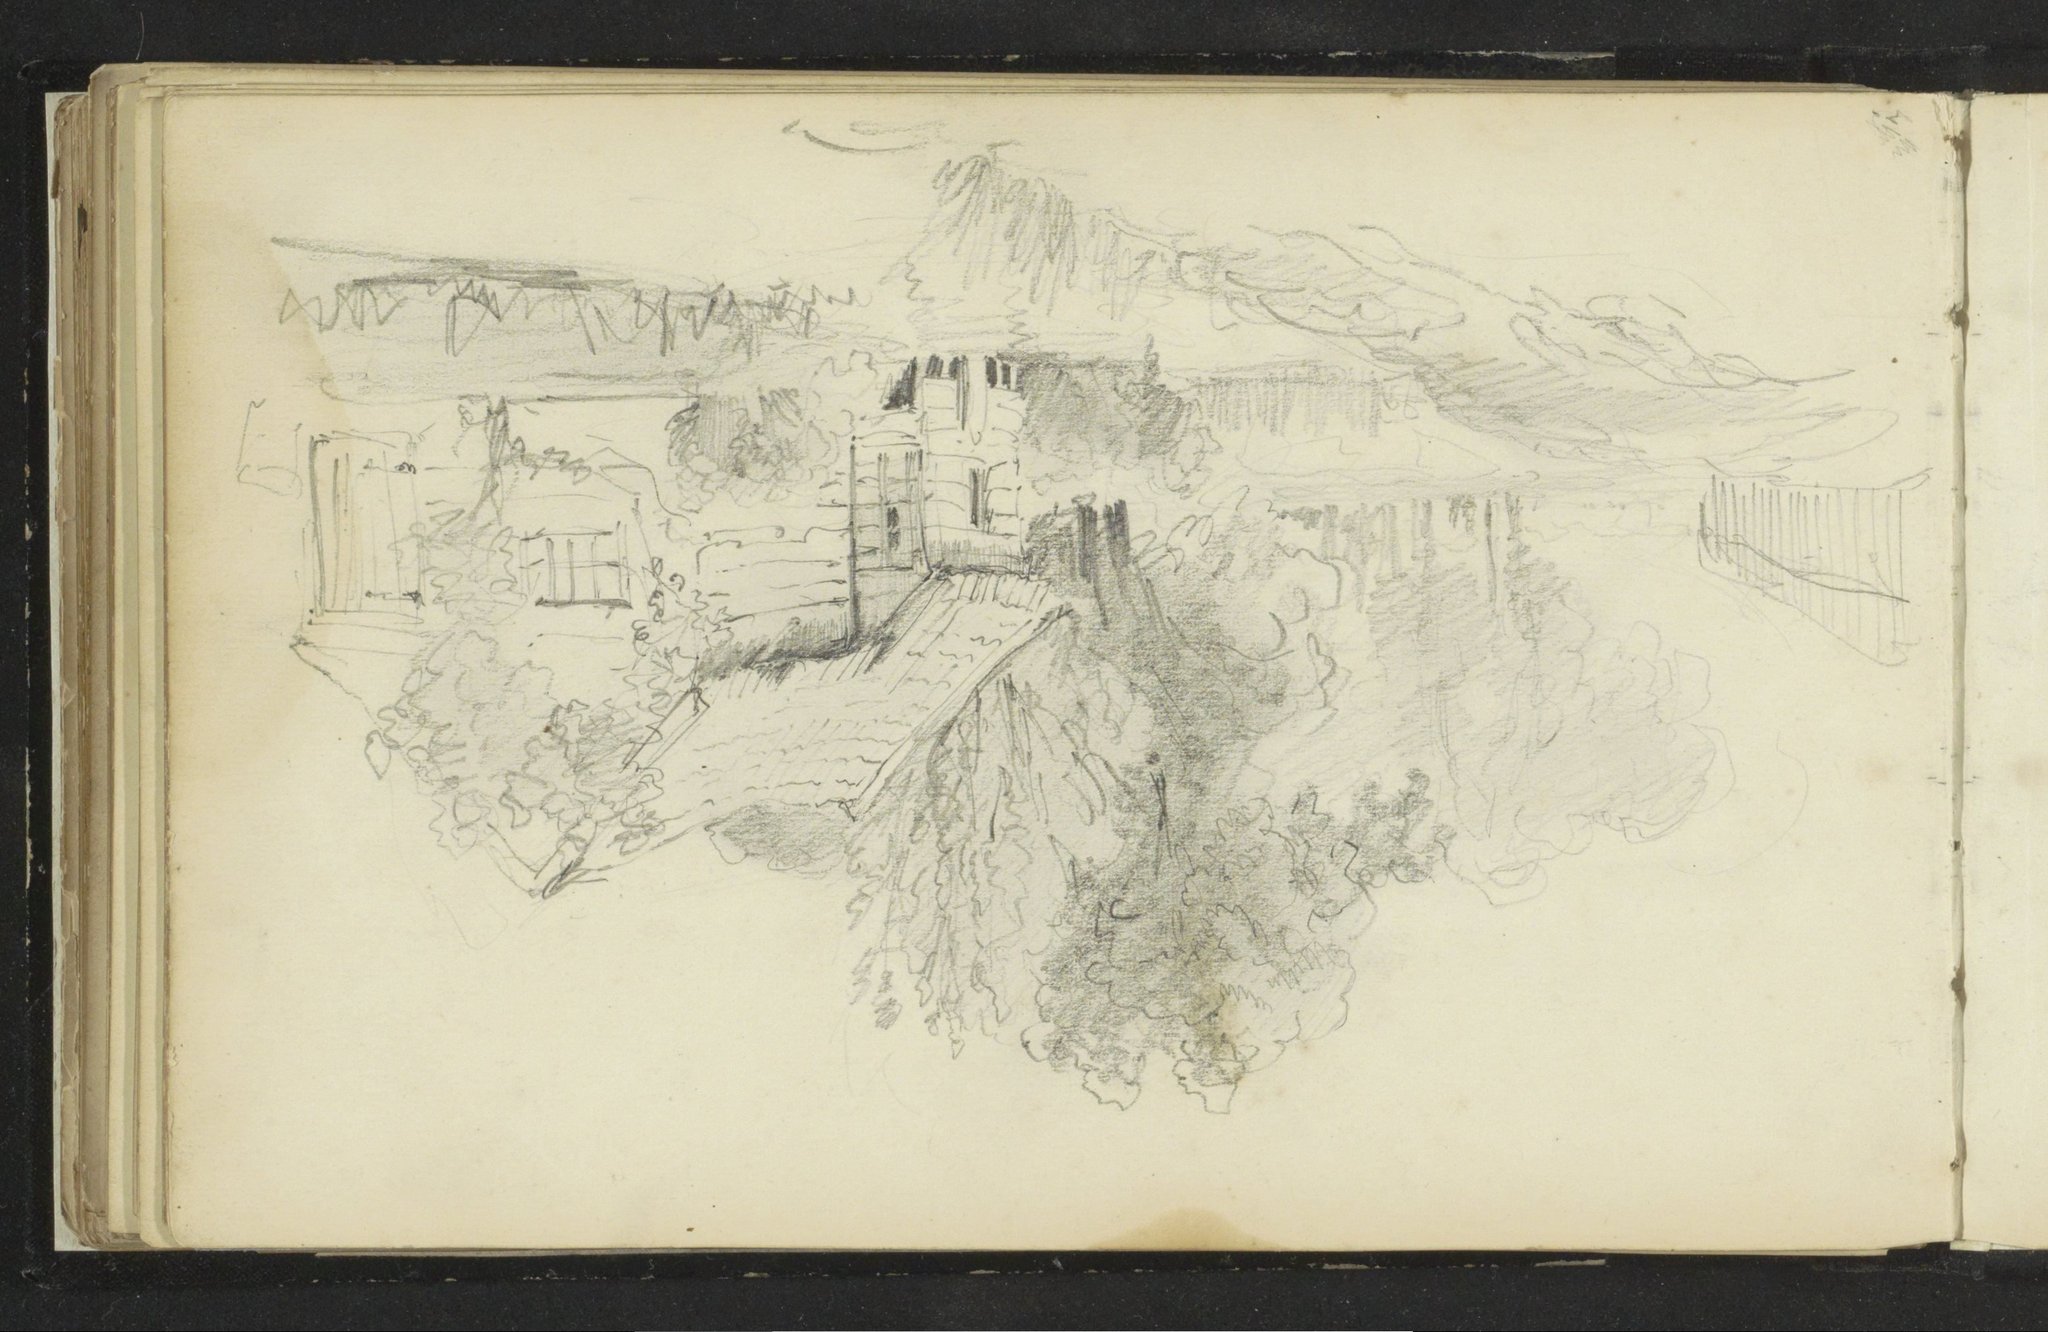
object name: sketchbook leaf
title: Gezicht op een gebouw aan het water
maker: cornelis springer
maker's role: draughtsman, painter, print maker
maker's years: 1817-1891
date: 1846-1882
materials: paper, pencil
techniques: stumping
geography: netherlands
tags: landscapes with waters, waterscapes, seascapes (in the temperate zone), rural housing, e.g. country-house, villa, cottage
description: Gezicht op een gebouw aan het water. Blad 90 verso uit een schetsboek met 91 bladen.